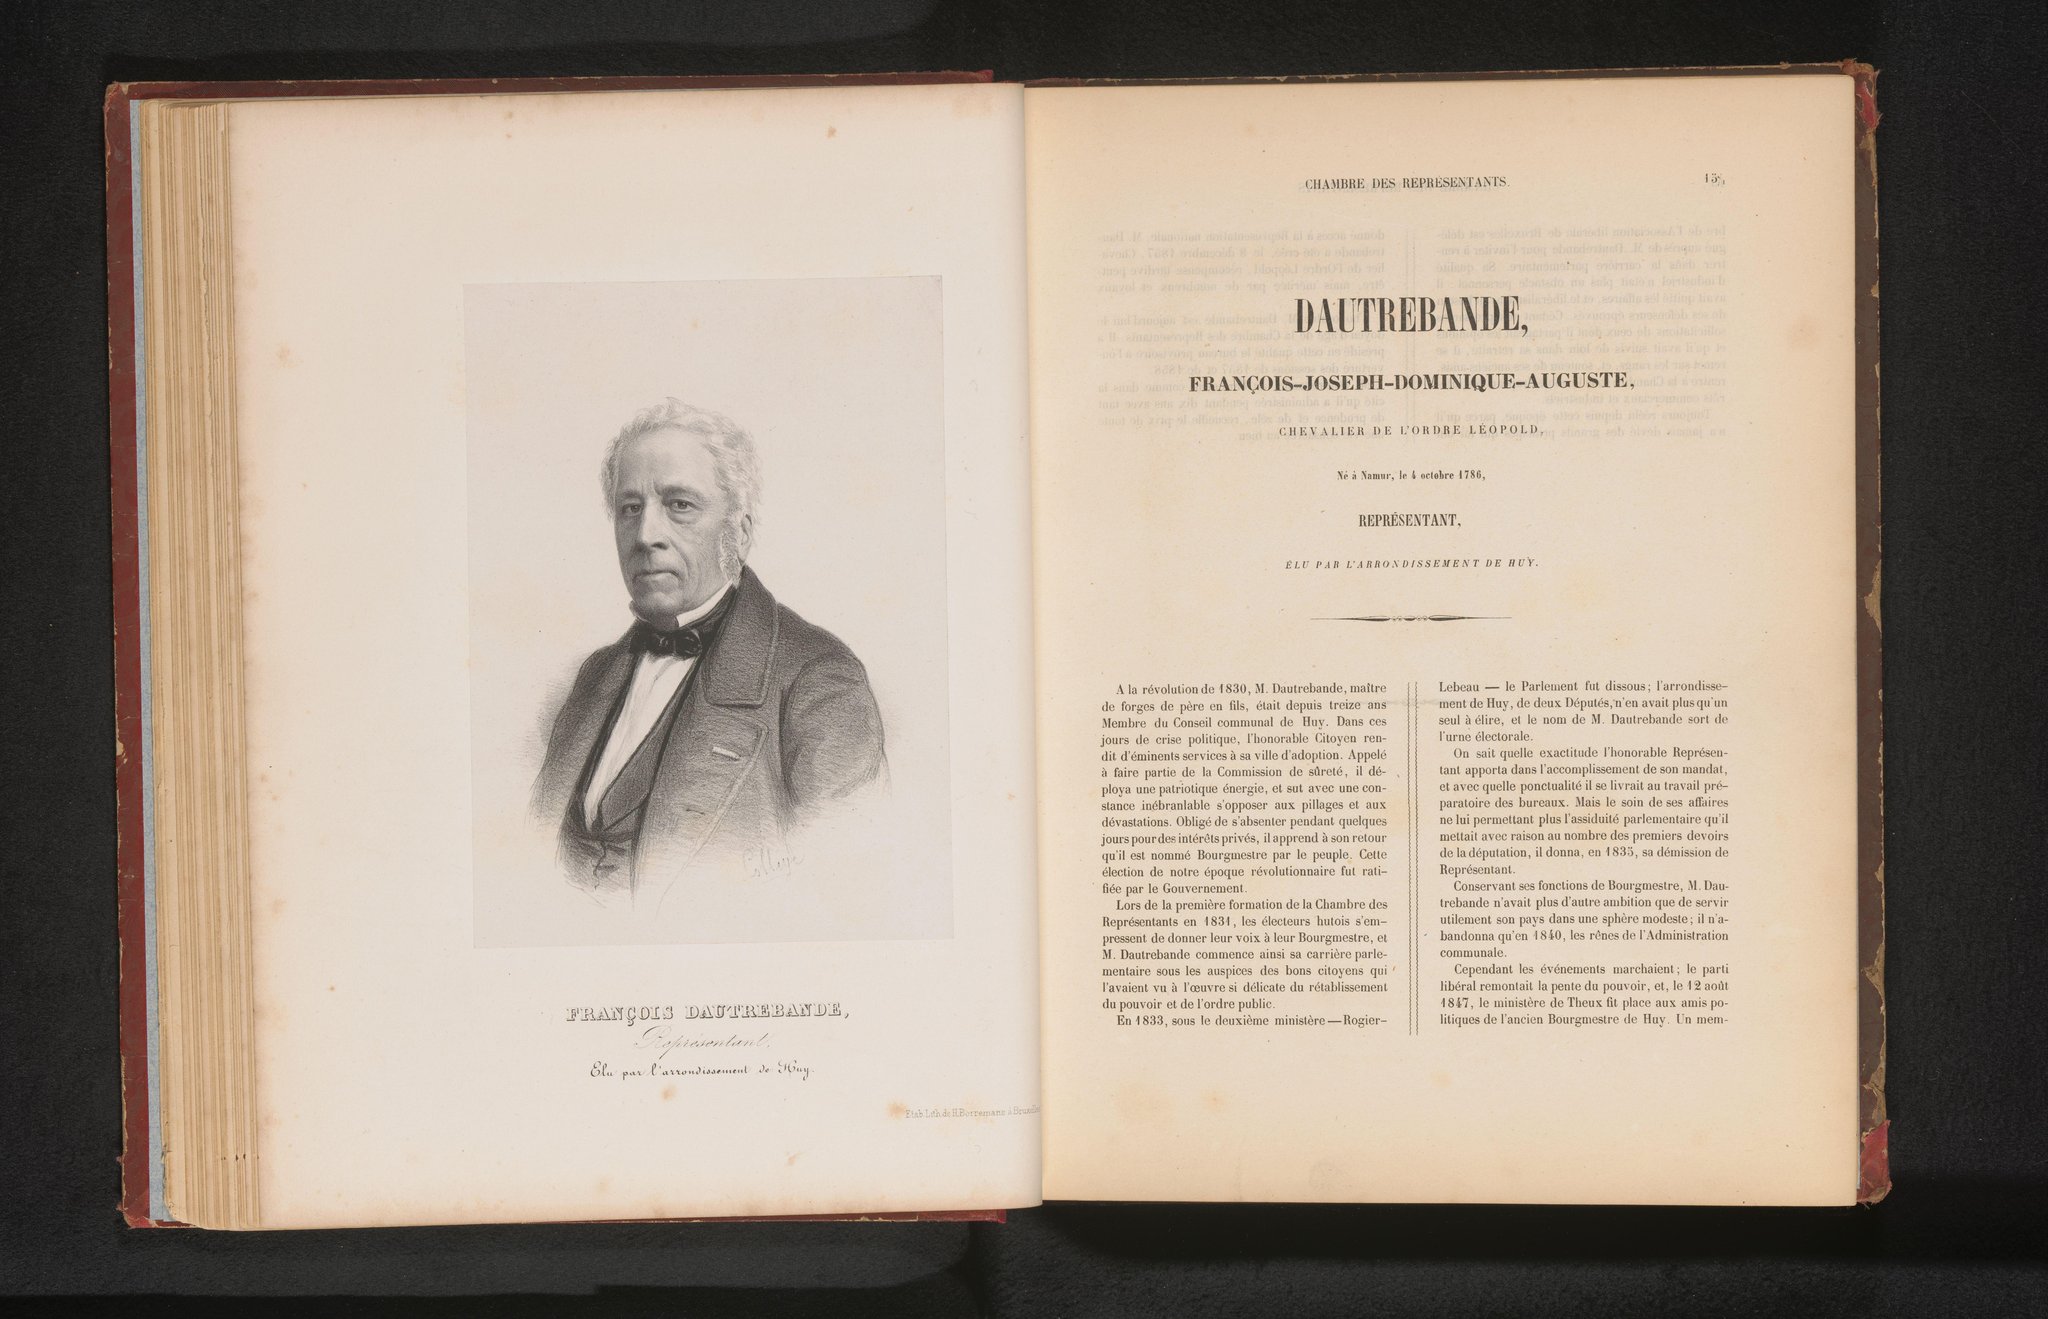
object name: print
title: Reproductie van een foto van een portret van François Dautrebande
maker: henri borremans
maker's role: print maker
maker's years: 1800-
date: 1853-1858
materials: paper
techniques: lithograph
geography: brussels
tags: politician, historical persons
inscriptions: inscription: ‘Représentant,/ Elu par l'arrondissement de Huy.’